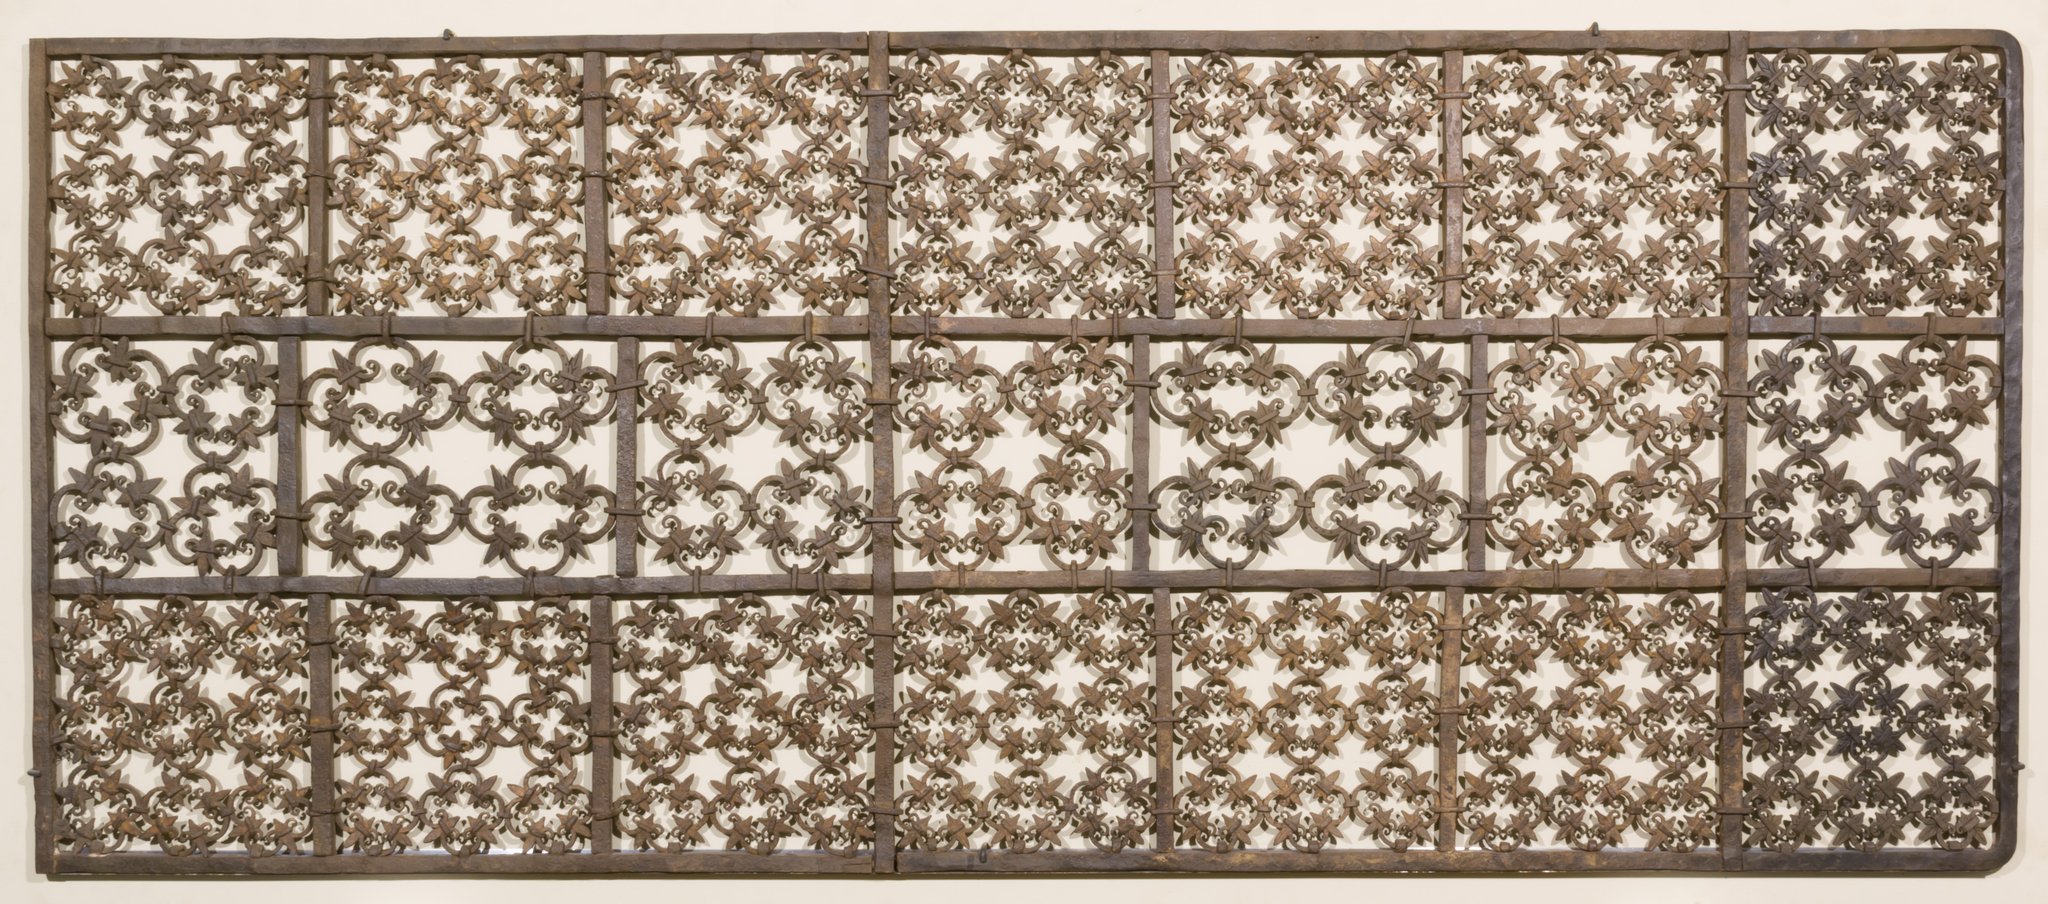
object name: grill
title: Grille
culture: italian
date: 1501-1600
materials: iron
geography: italy